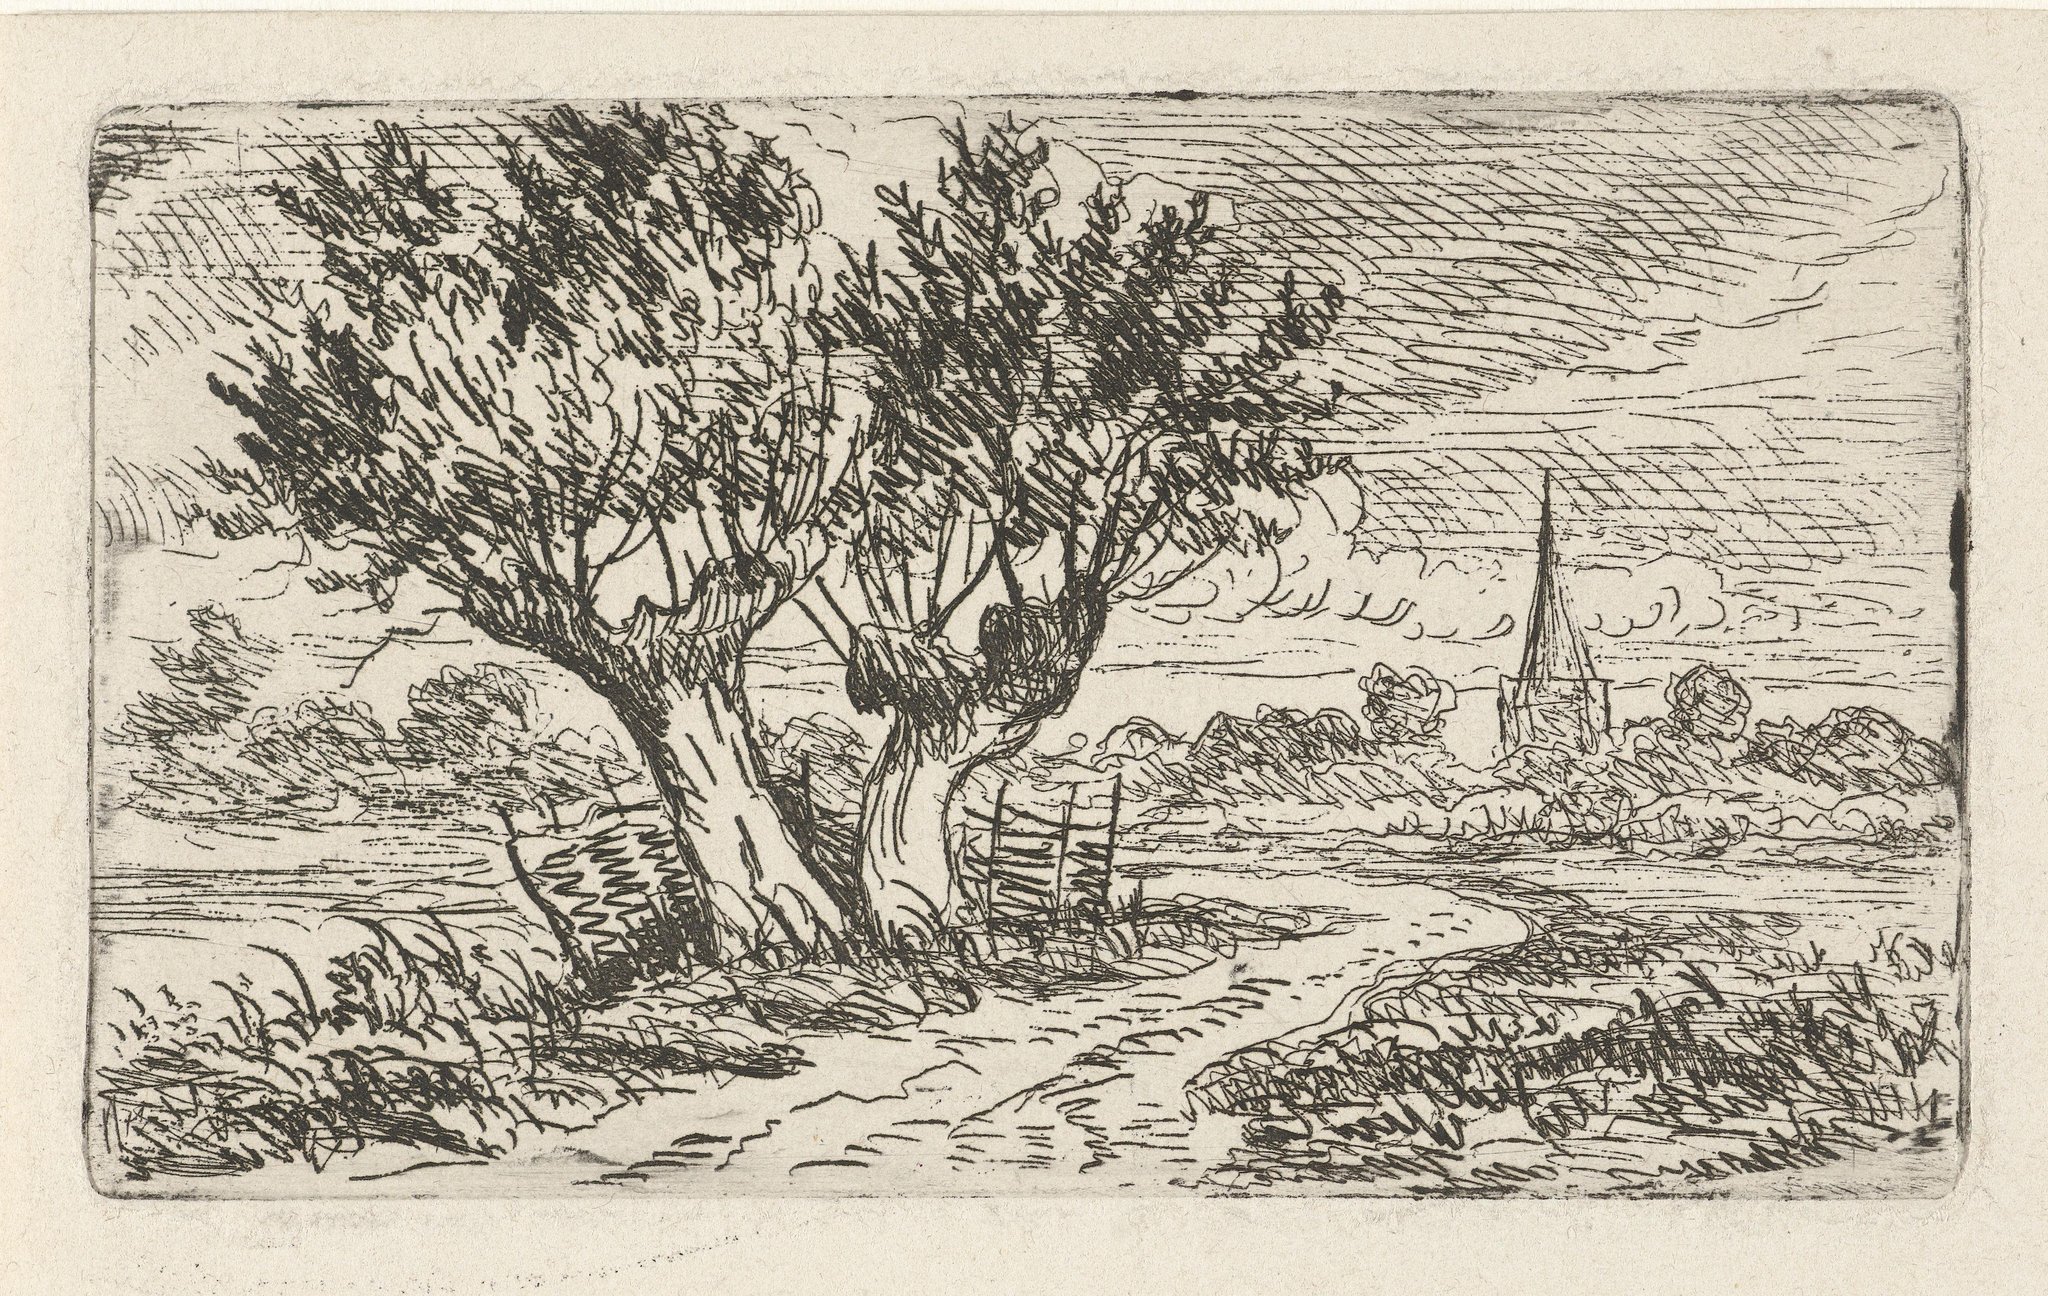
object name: print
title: Landschap met wilgen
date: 1837-1880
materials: paper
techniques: etching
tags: trees: willow, public road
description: Landschap met een weg naast een paar wilgen.